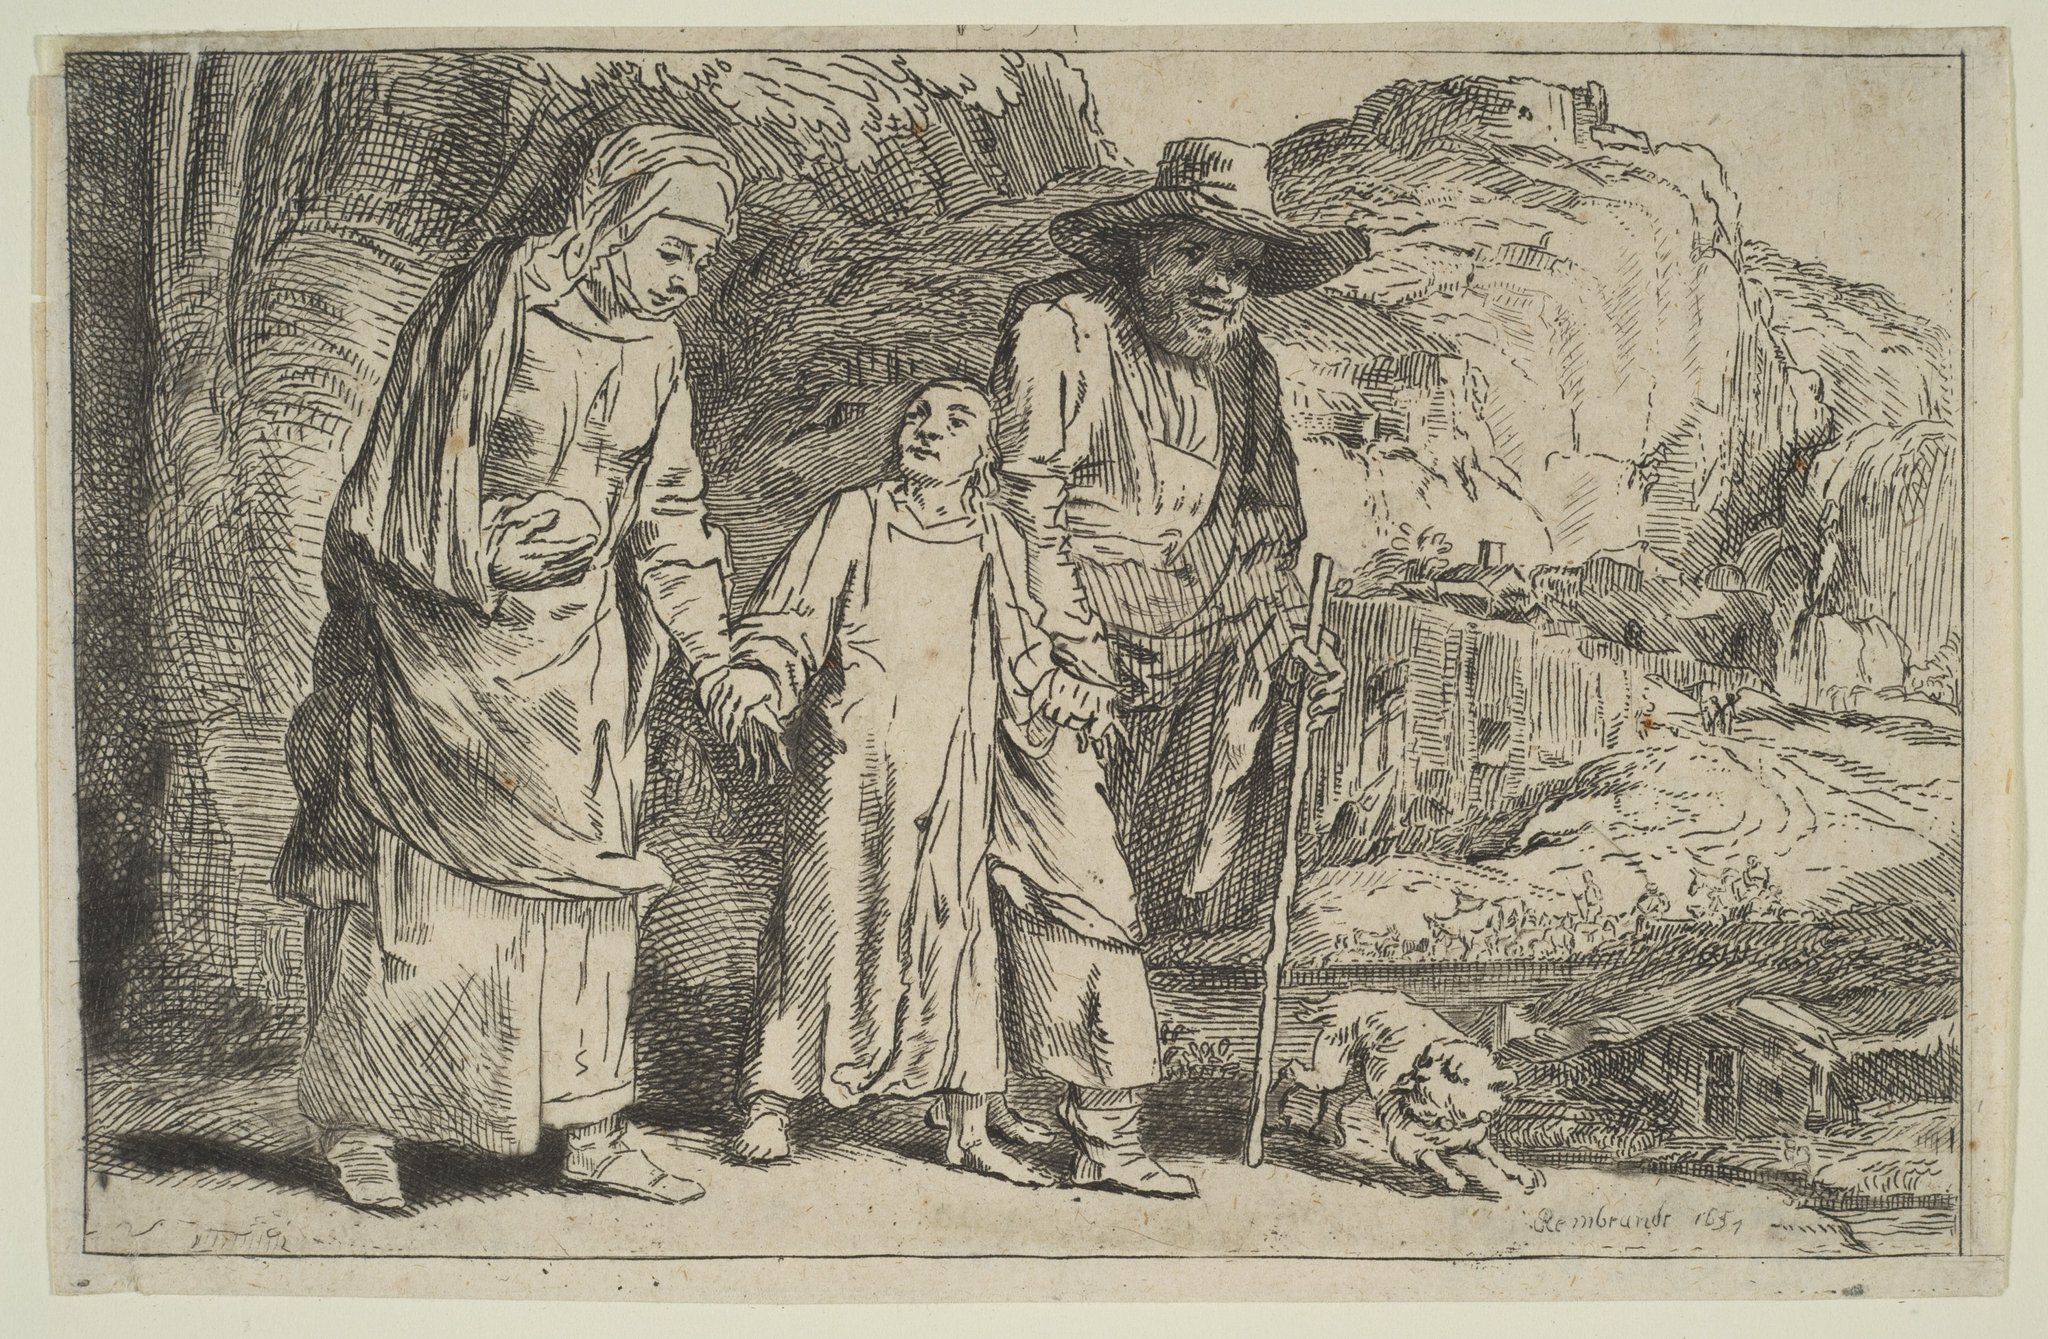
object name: print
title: Christ Between His Parents Returning from the Temple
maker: baron dominique vivant denon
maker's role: etcher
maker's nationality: french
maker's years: 1747-1825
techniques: etching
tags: dogs,christ,saint joseph,virgin mary